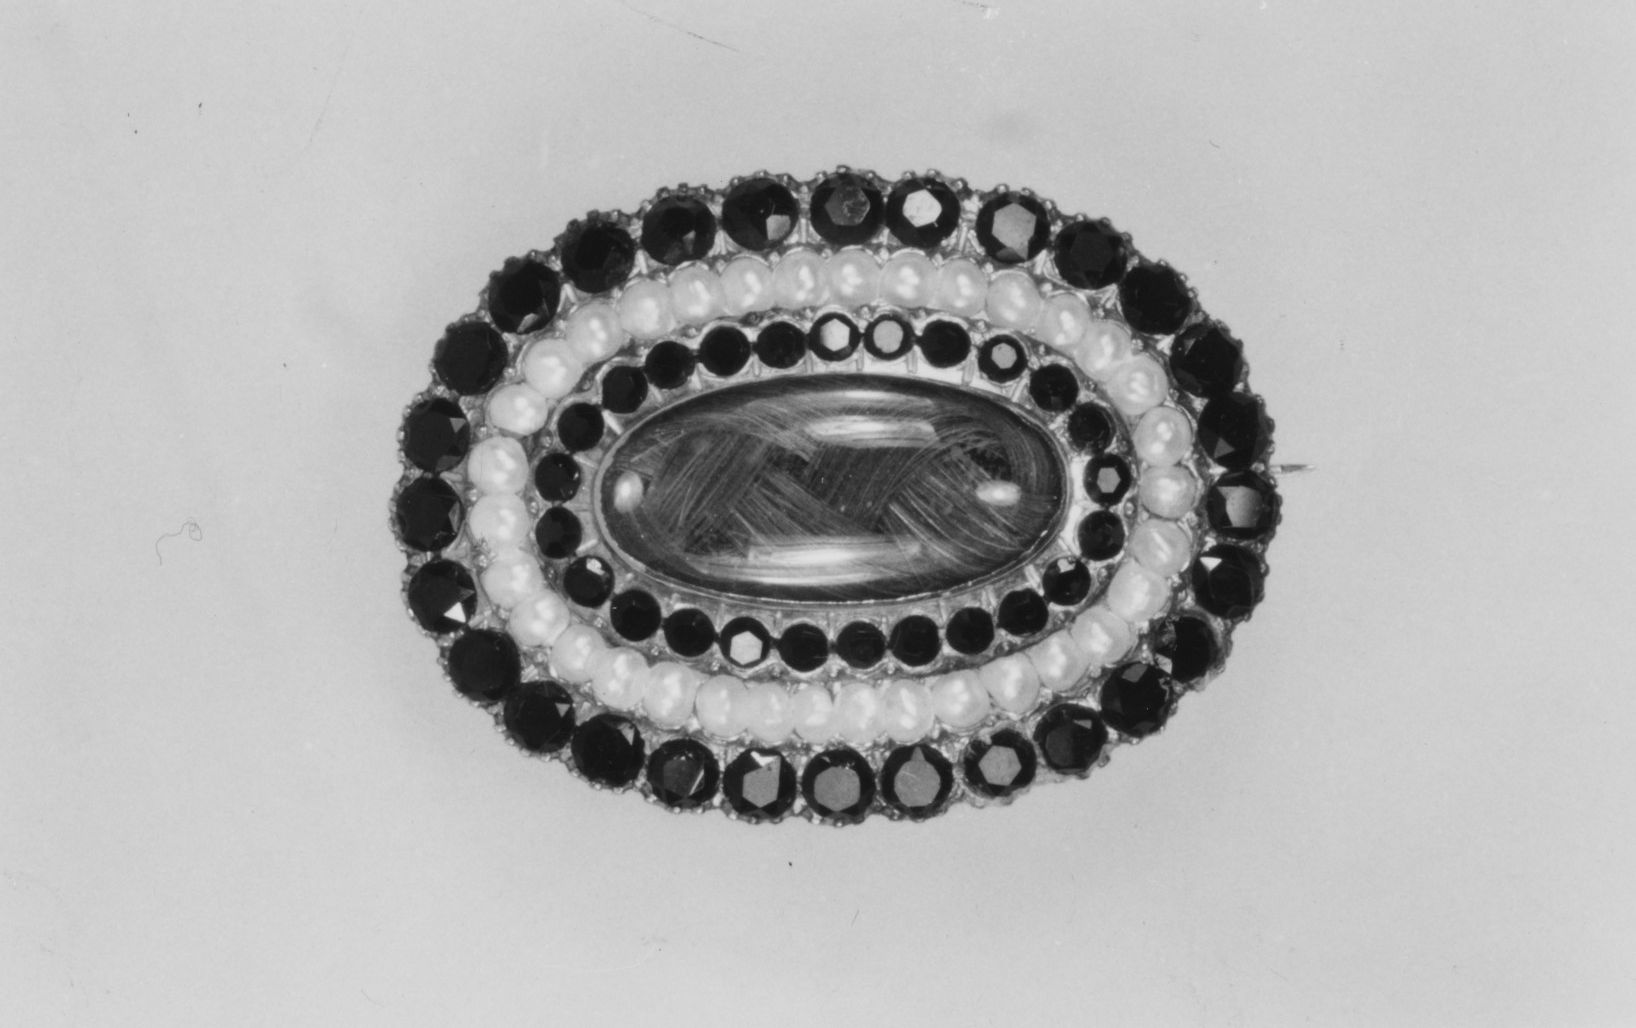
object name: brooch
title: Mourning Pin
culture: american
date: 1862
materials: gold, pearl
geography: united states